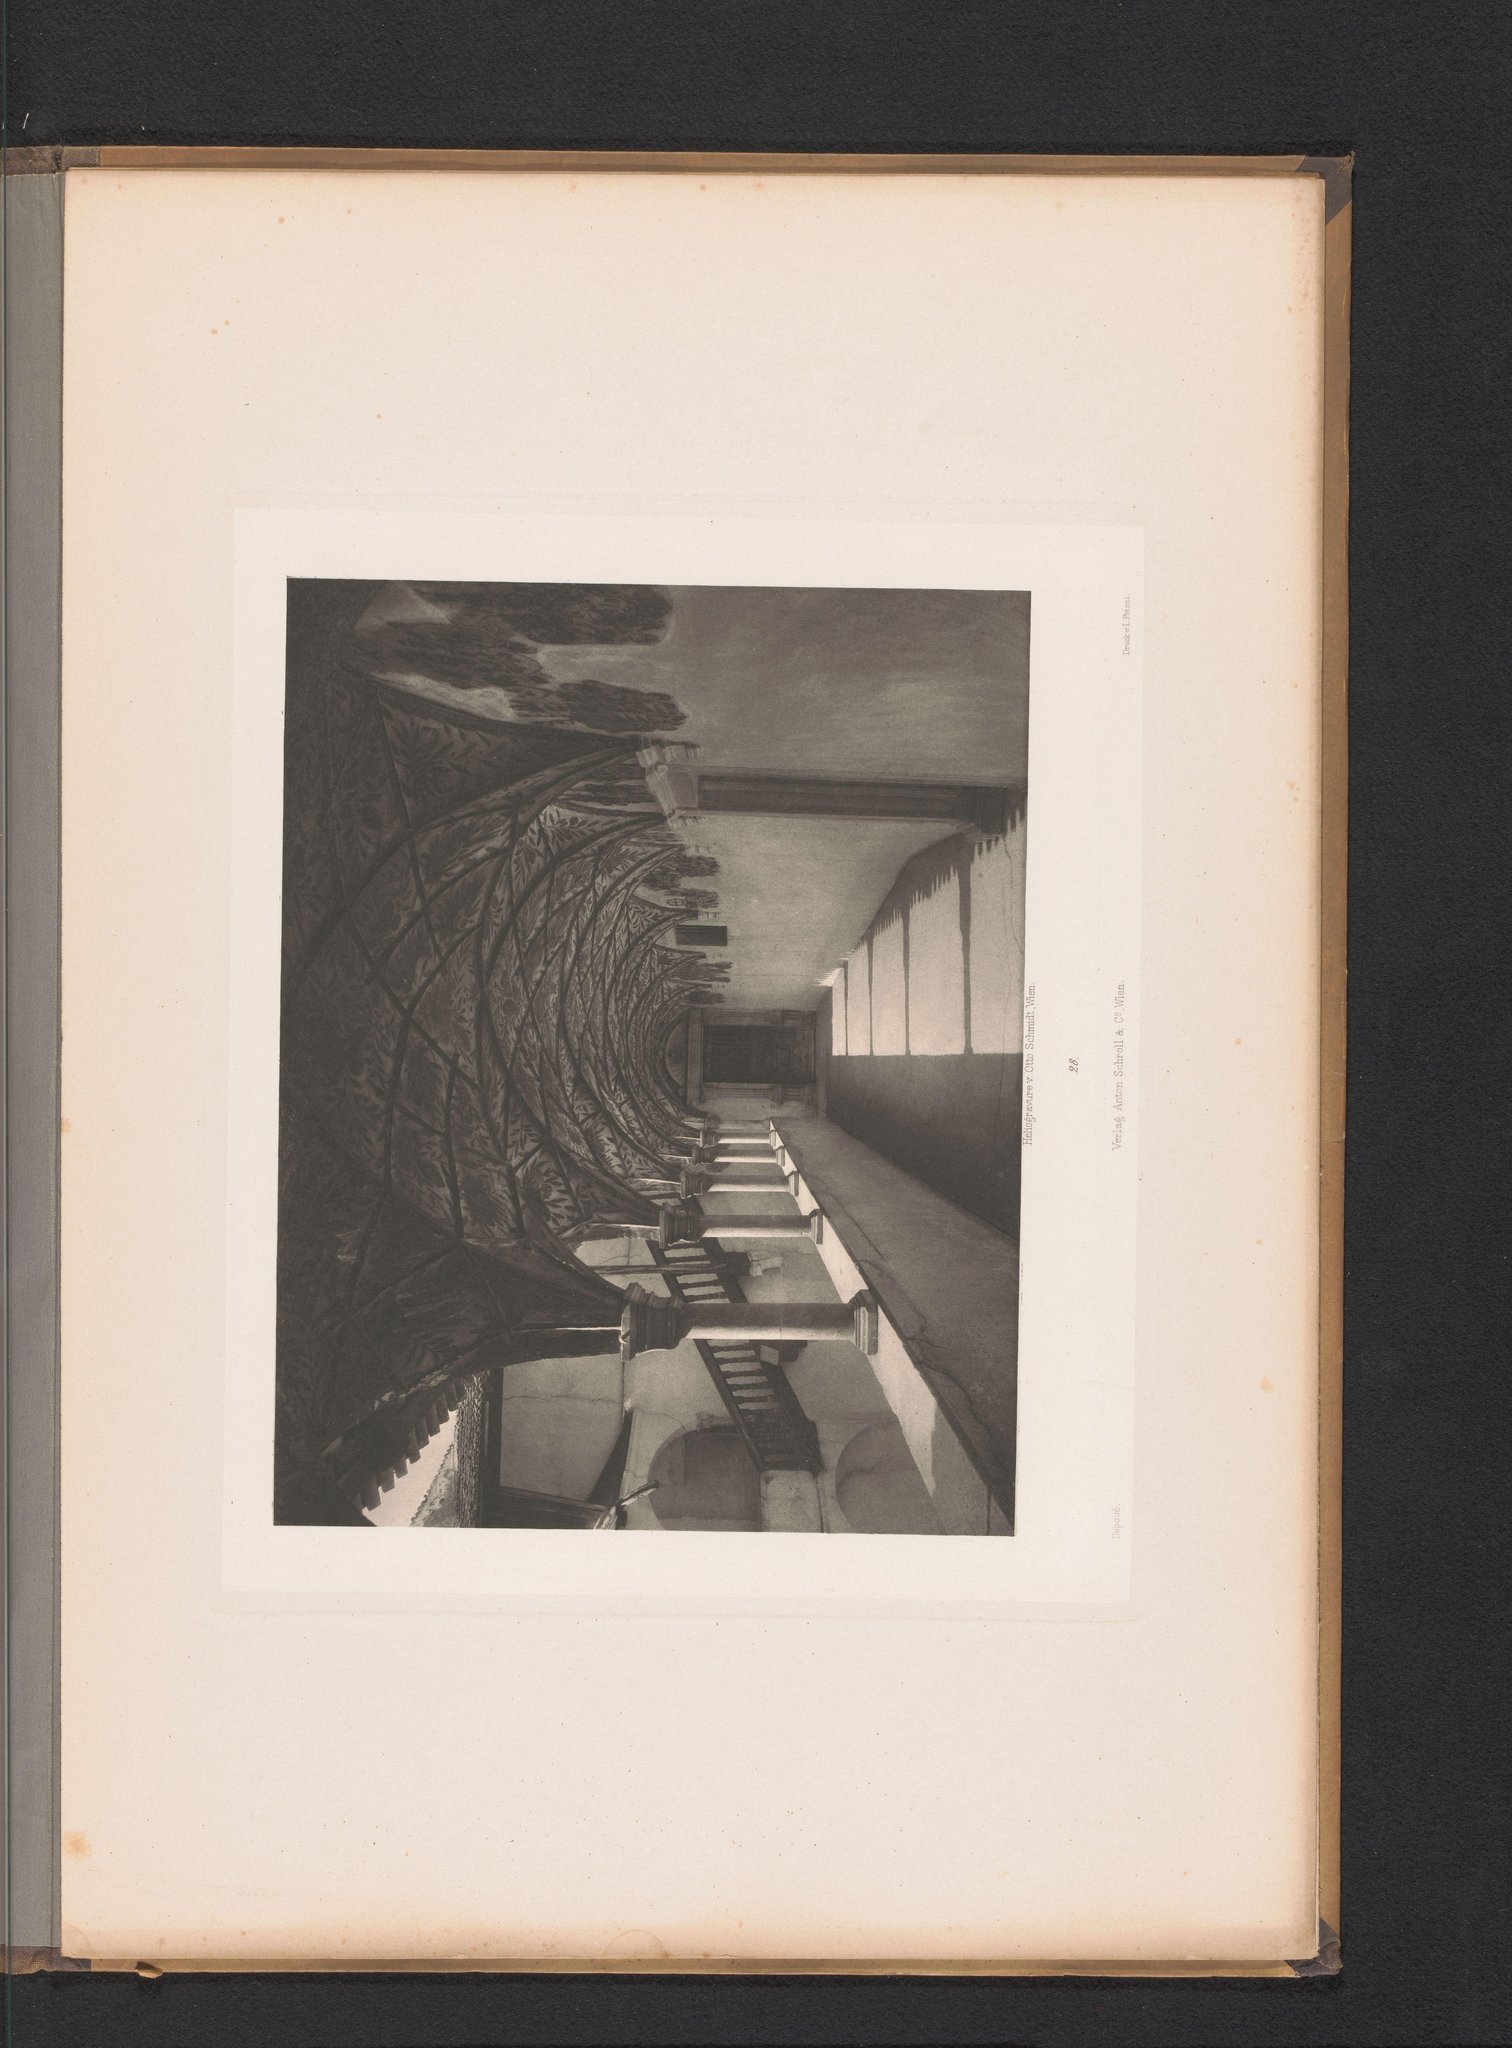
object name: photomechanical print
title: Galerij van Slot Dornsberg in Vintzgouw in Zuid-Tirol, Italië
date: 1886-1891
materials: paper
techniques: photoaquatint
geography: south tyrol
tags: castle, gallery (spacious corridor)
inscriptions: number: ‘28.’, inscription: ‘Déposé.’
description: Deze prent maakt deel uit van een omslag met dertig prenten en drie tekstbladen.